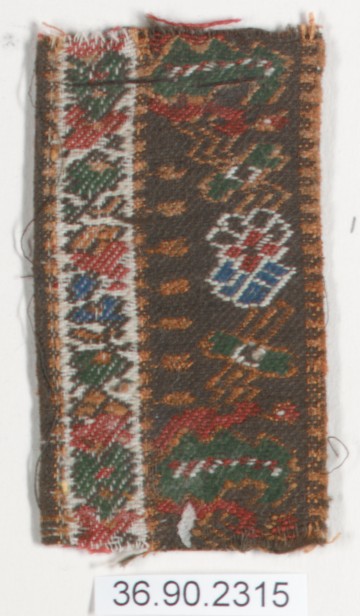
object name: border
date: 1801-1900